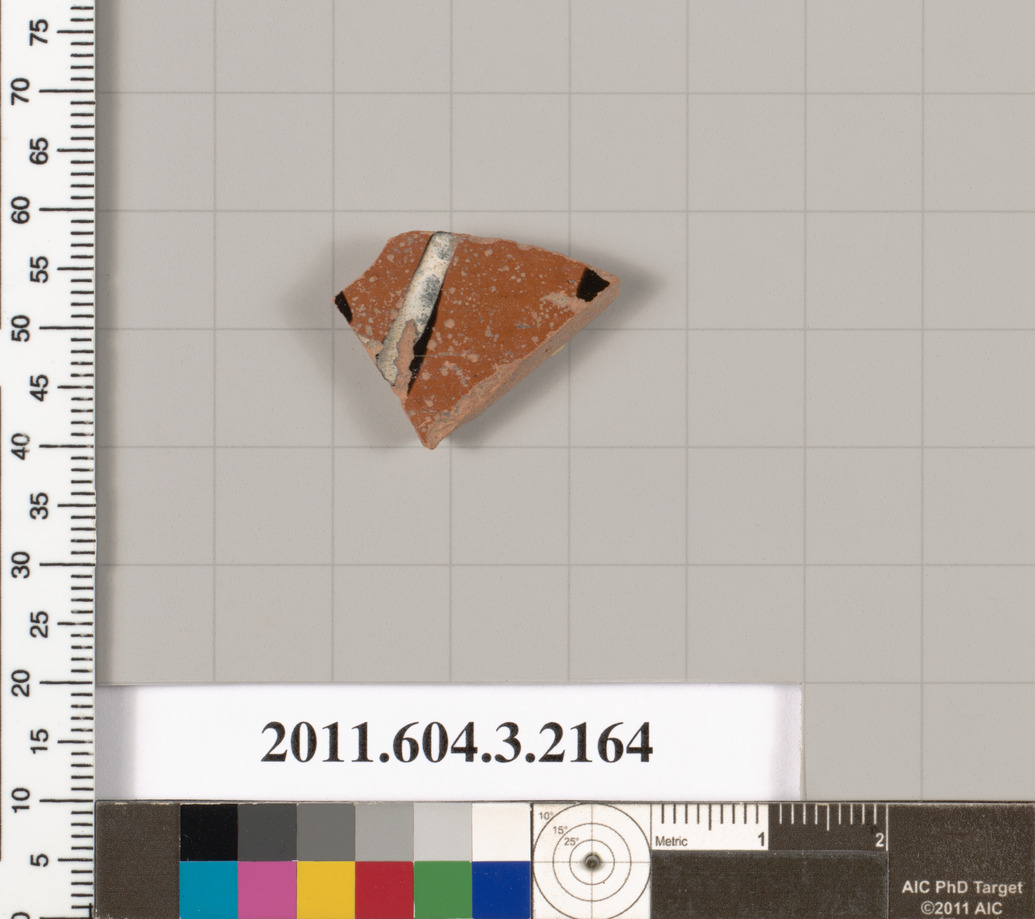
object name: kylix fragment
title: Terracotta fragment of a kylix (drinking cup)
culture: greek, attic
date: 534-468 BCE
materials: terracotta